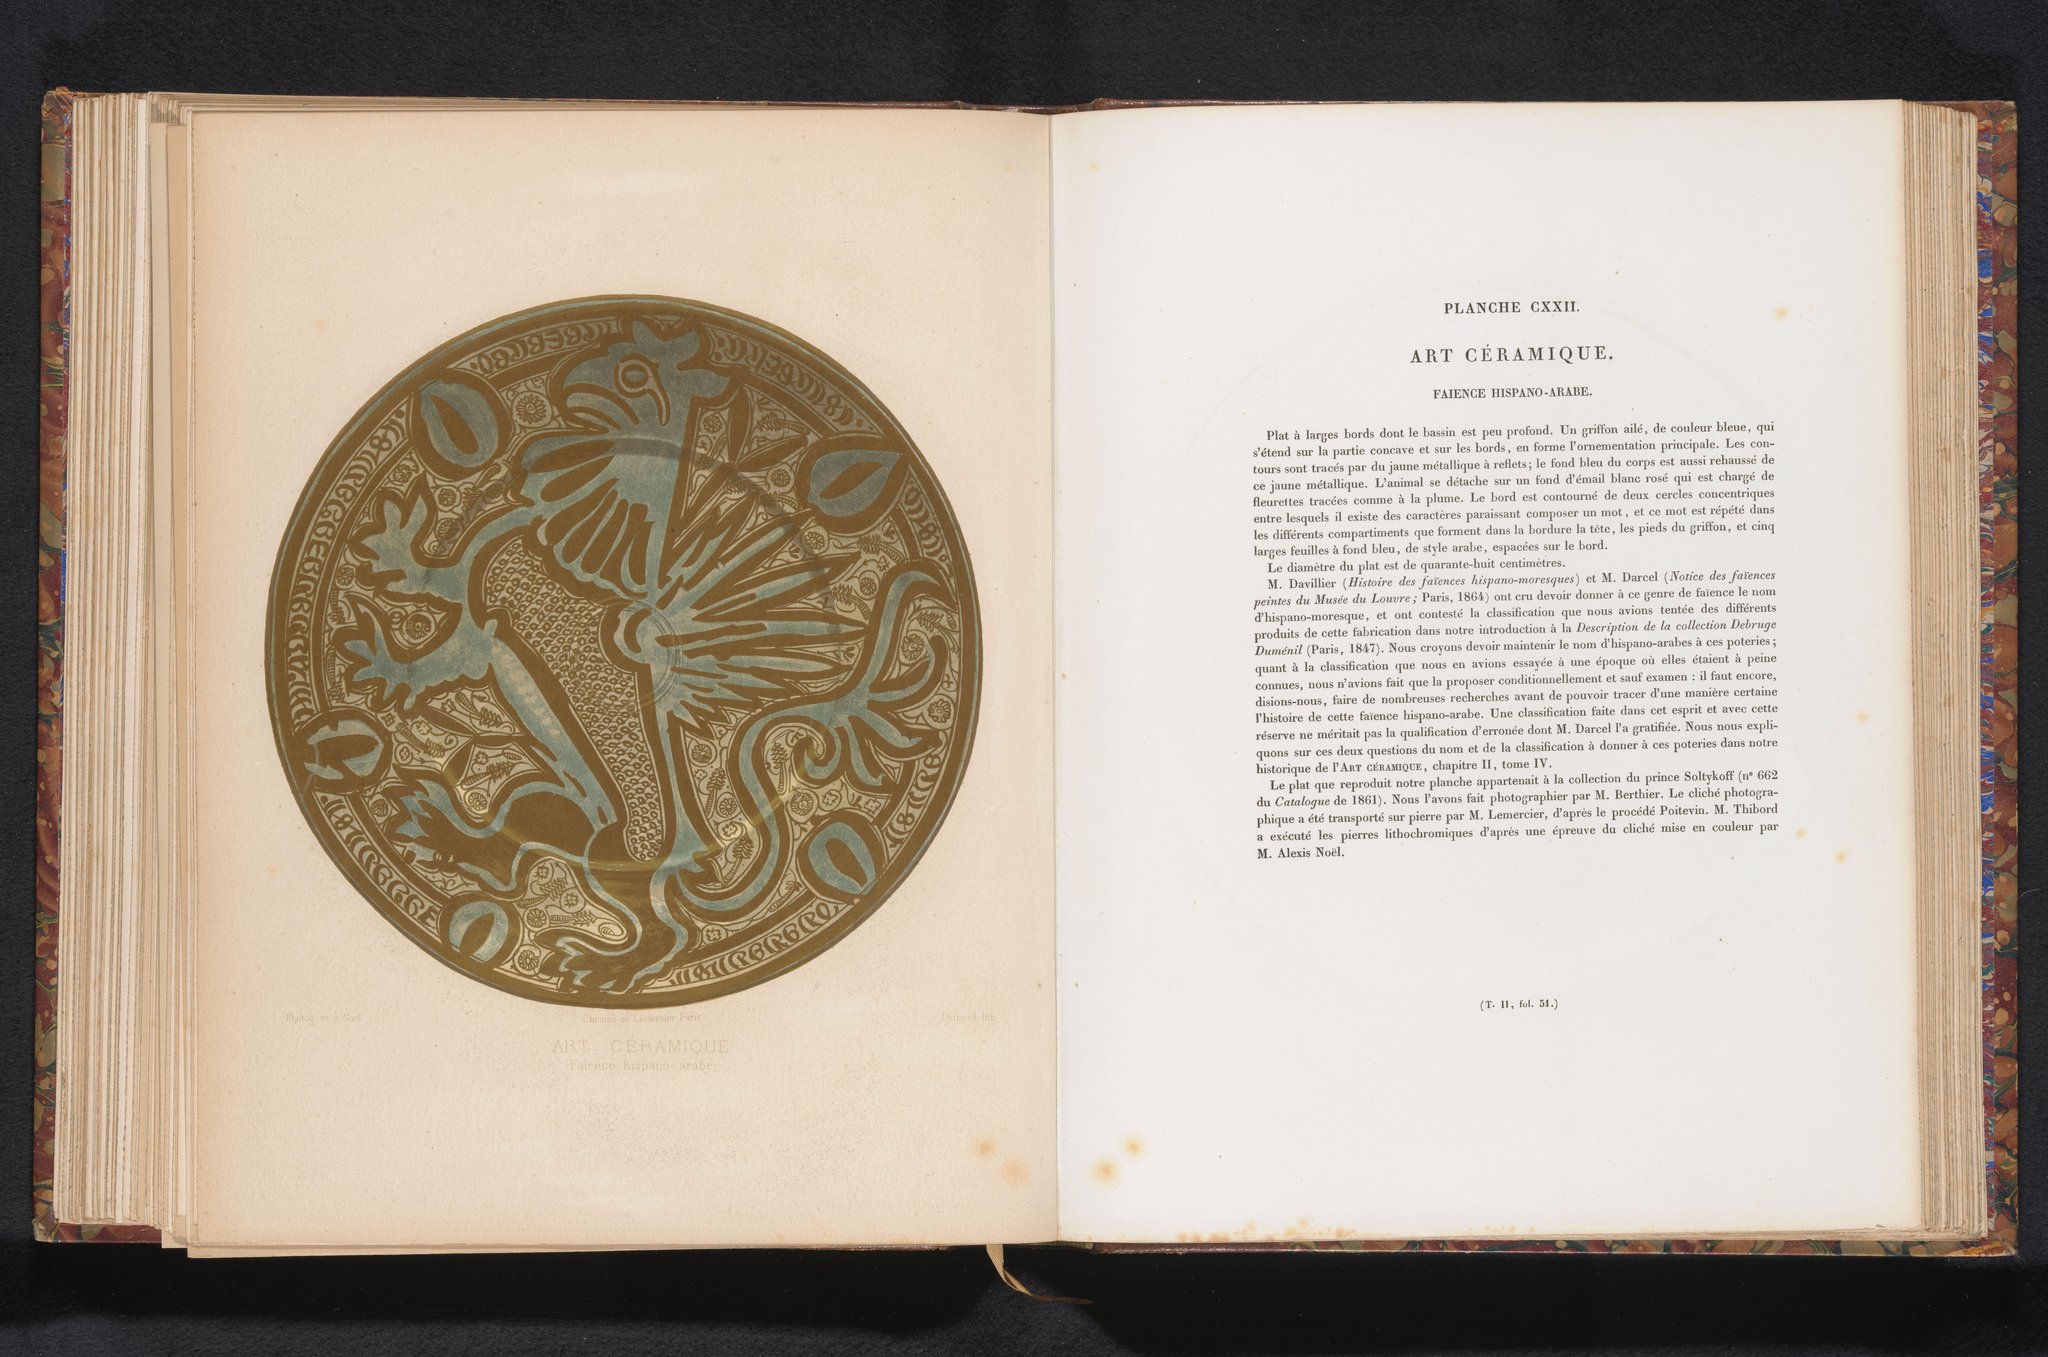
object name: page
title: Faïence hispano, arabe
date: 1859-1864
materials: paper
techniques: photolithography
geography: paris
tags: dish, plate, saucer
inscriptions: name: ‘Photog. et A. Noël/ Thibord lith’